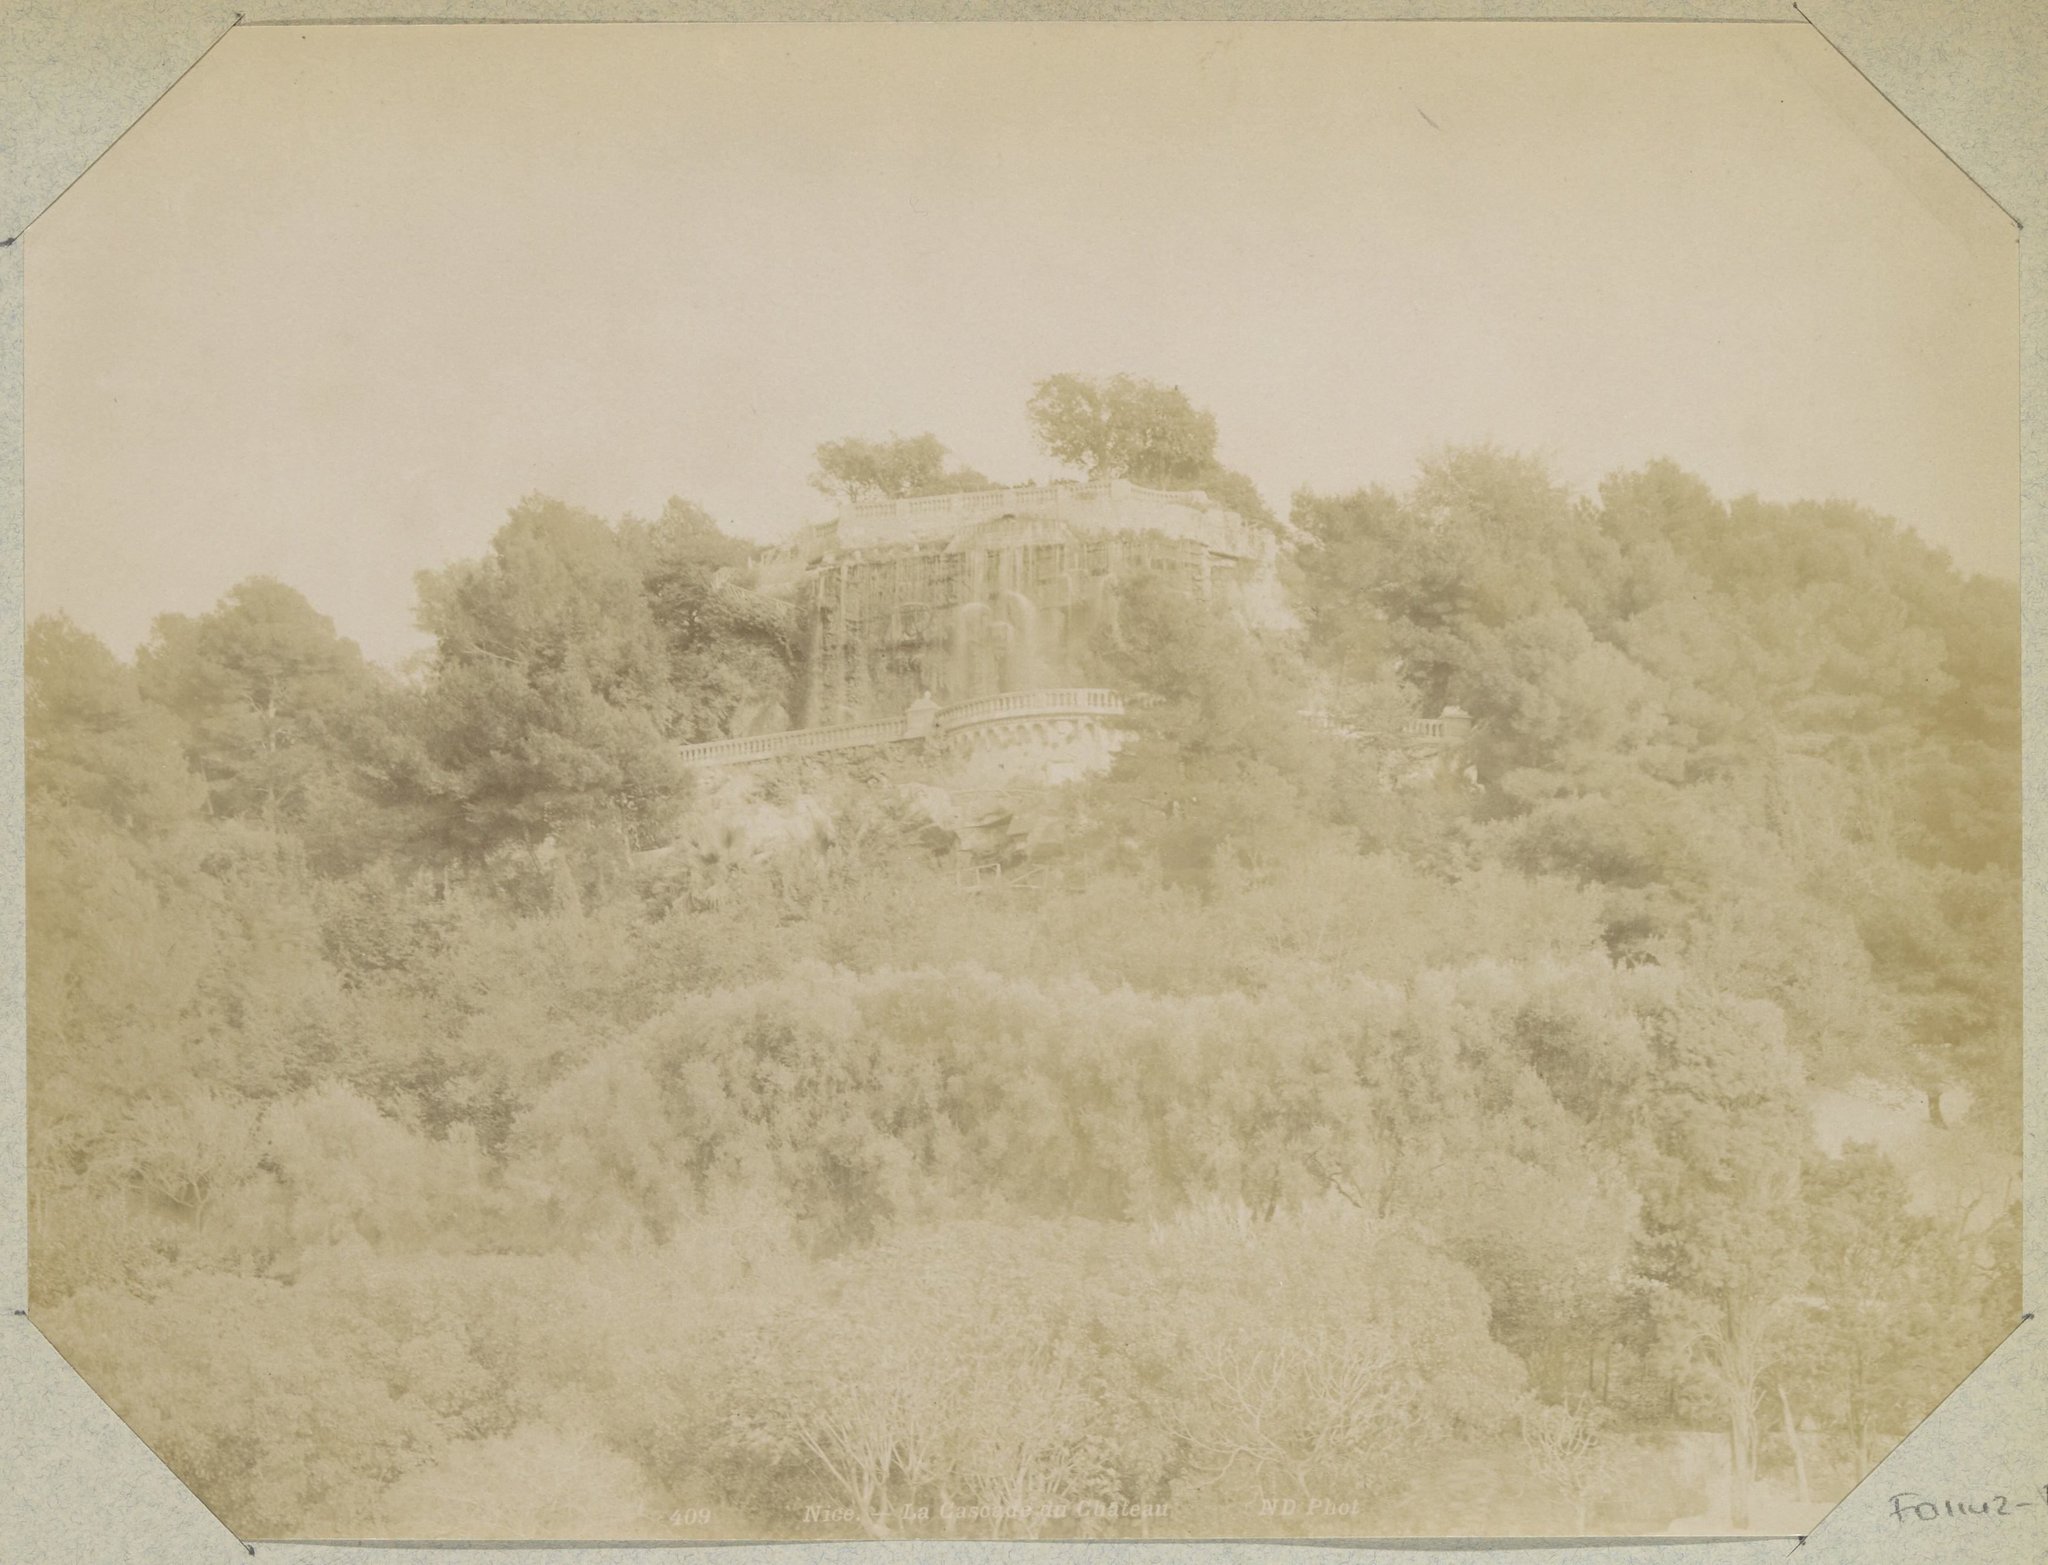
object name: photograph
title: Nice. - La Cascade du Château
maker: étienne neurdein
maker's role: publisher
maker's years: 1832-1918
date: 1890-1900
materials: paper, photographic support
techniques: albumen print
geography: nice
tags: castle, waterfall, garden cascade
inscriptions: negative number: ‘3388’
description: Onderdeel van Album van een Franse amateur met foto's van Frankrijk, Algerije, Palmyra, de Wereldtentoonstelling van 1900 en van bekende Fransen.